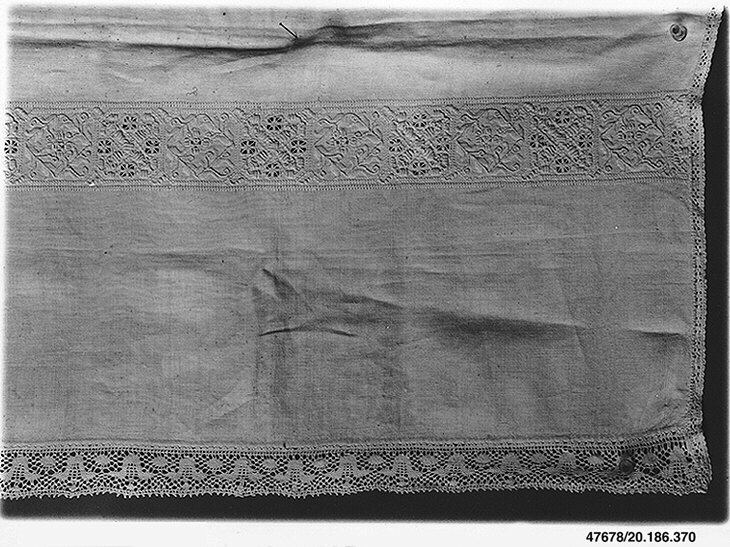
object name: altar cloth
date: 1600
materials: linen